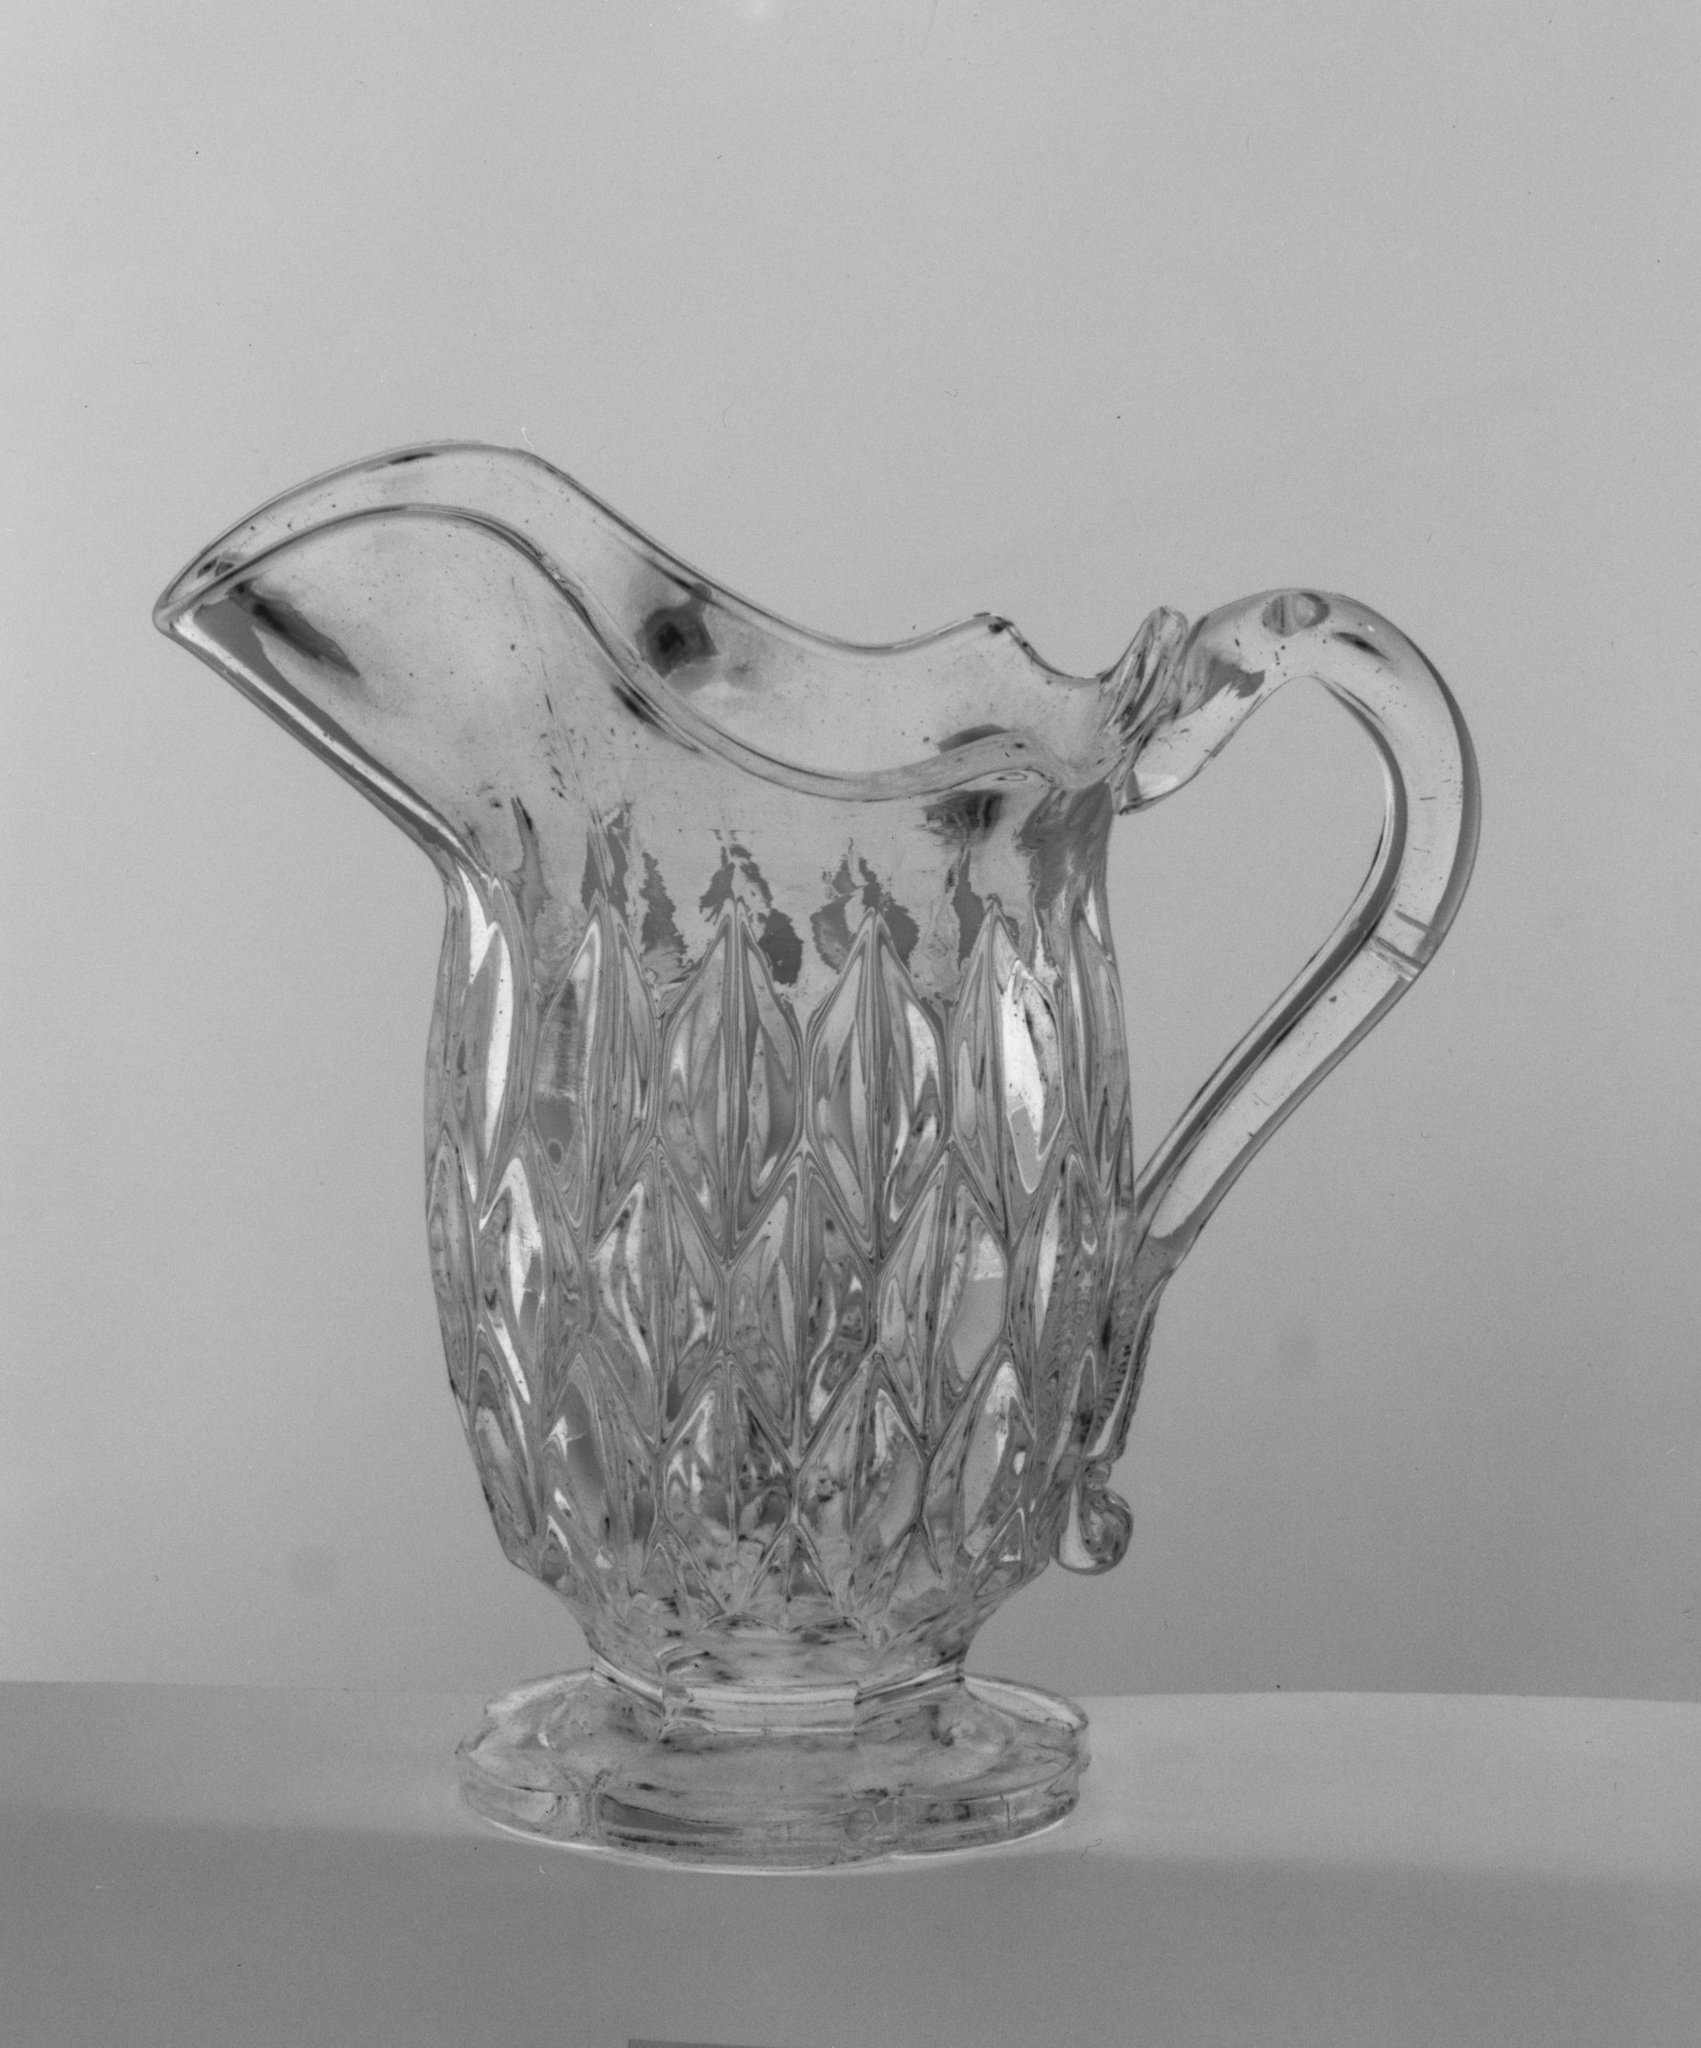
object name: pitcher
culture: american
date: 1850-1870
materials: glass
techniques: pressed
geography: united states